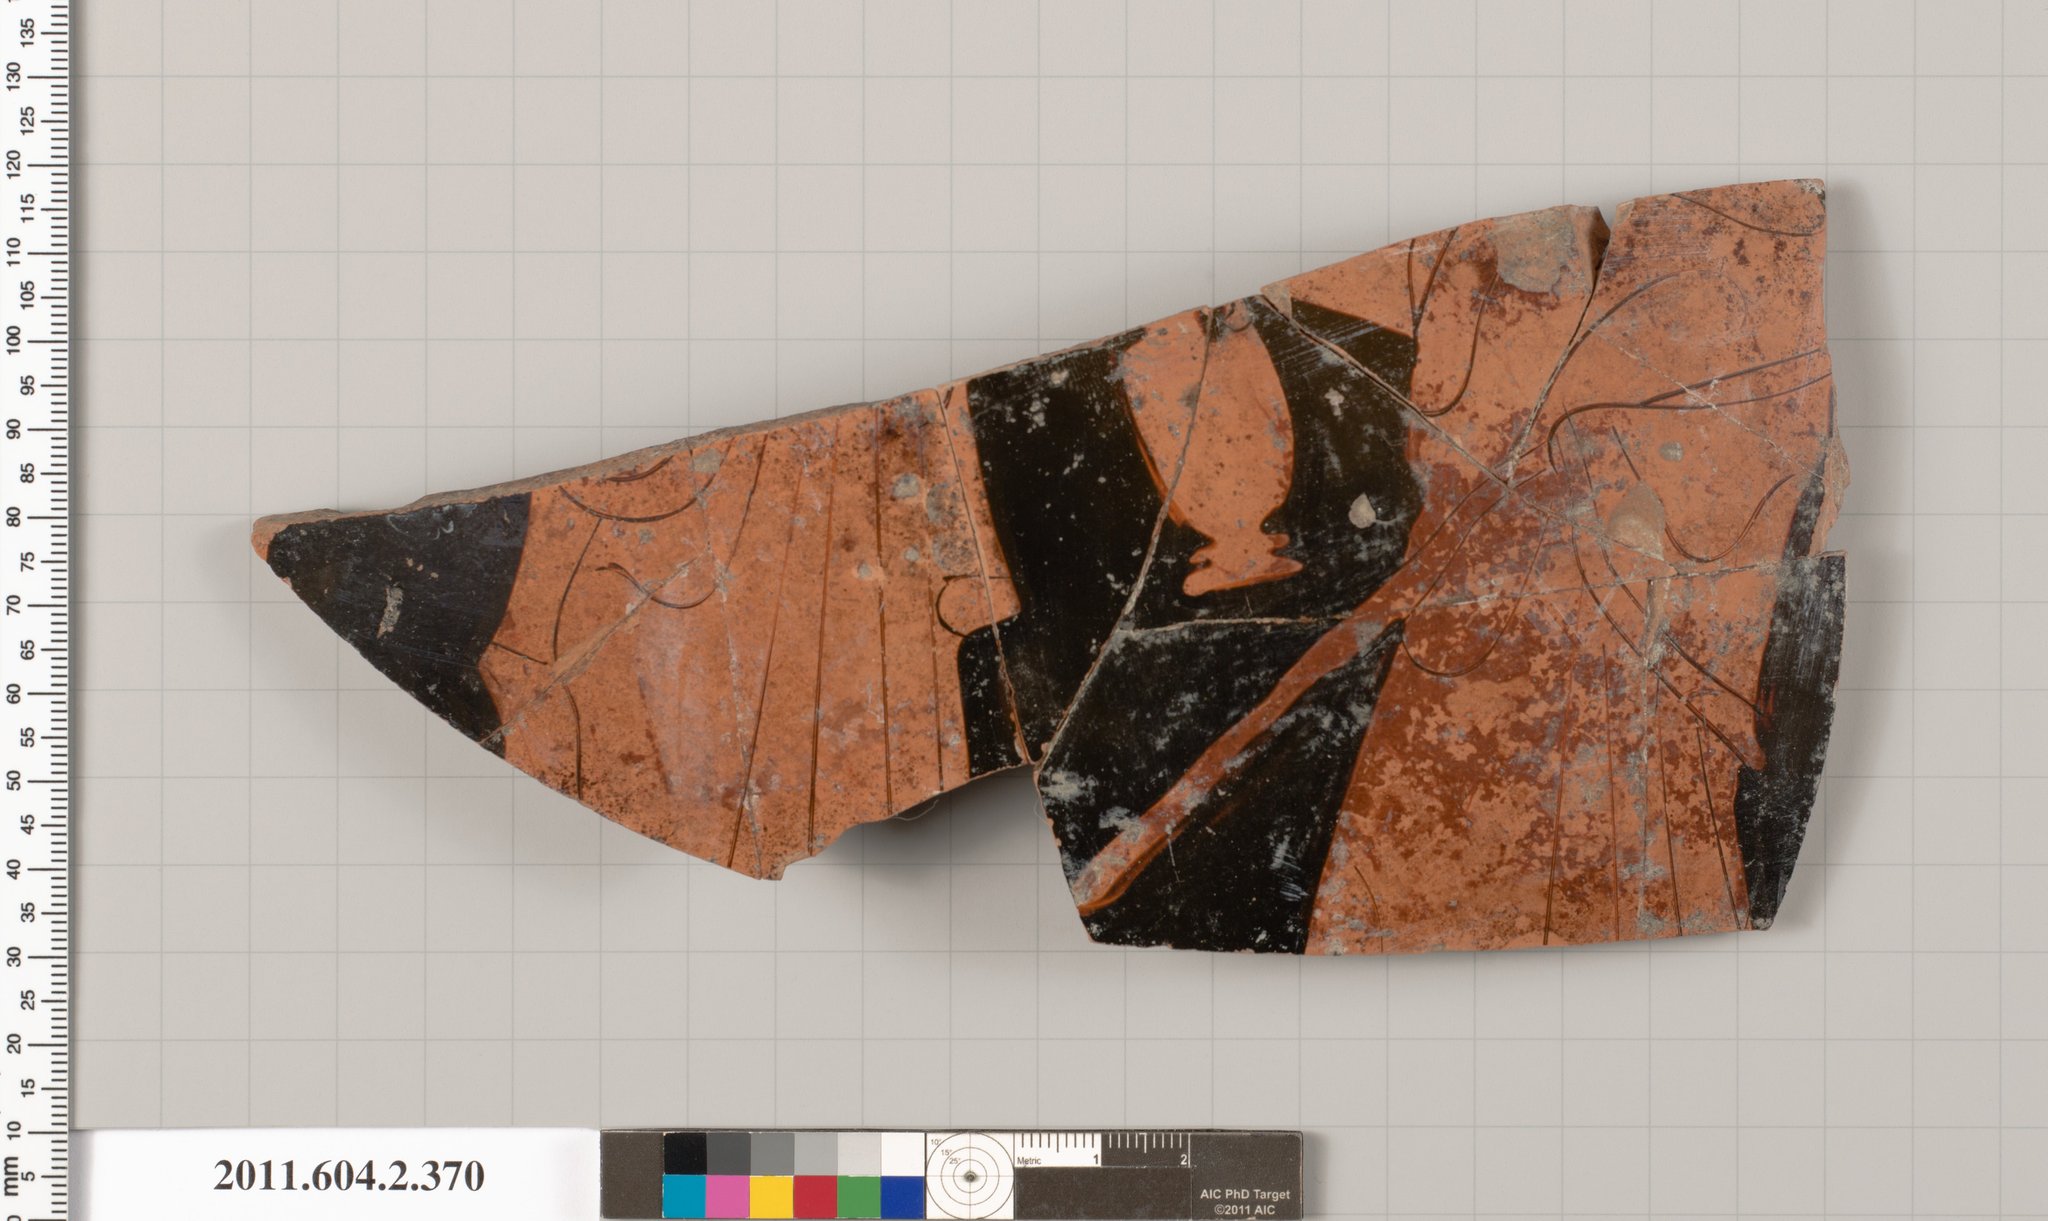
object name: column krater fragment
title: Terracotta fragment of a column-krater (bowl for mixing wine and water)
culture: greek, attic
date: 450-430 BCE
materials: terracotta